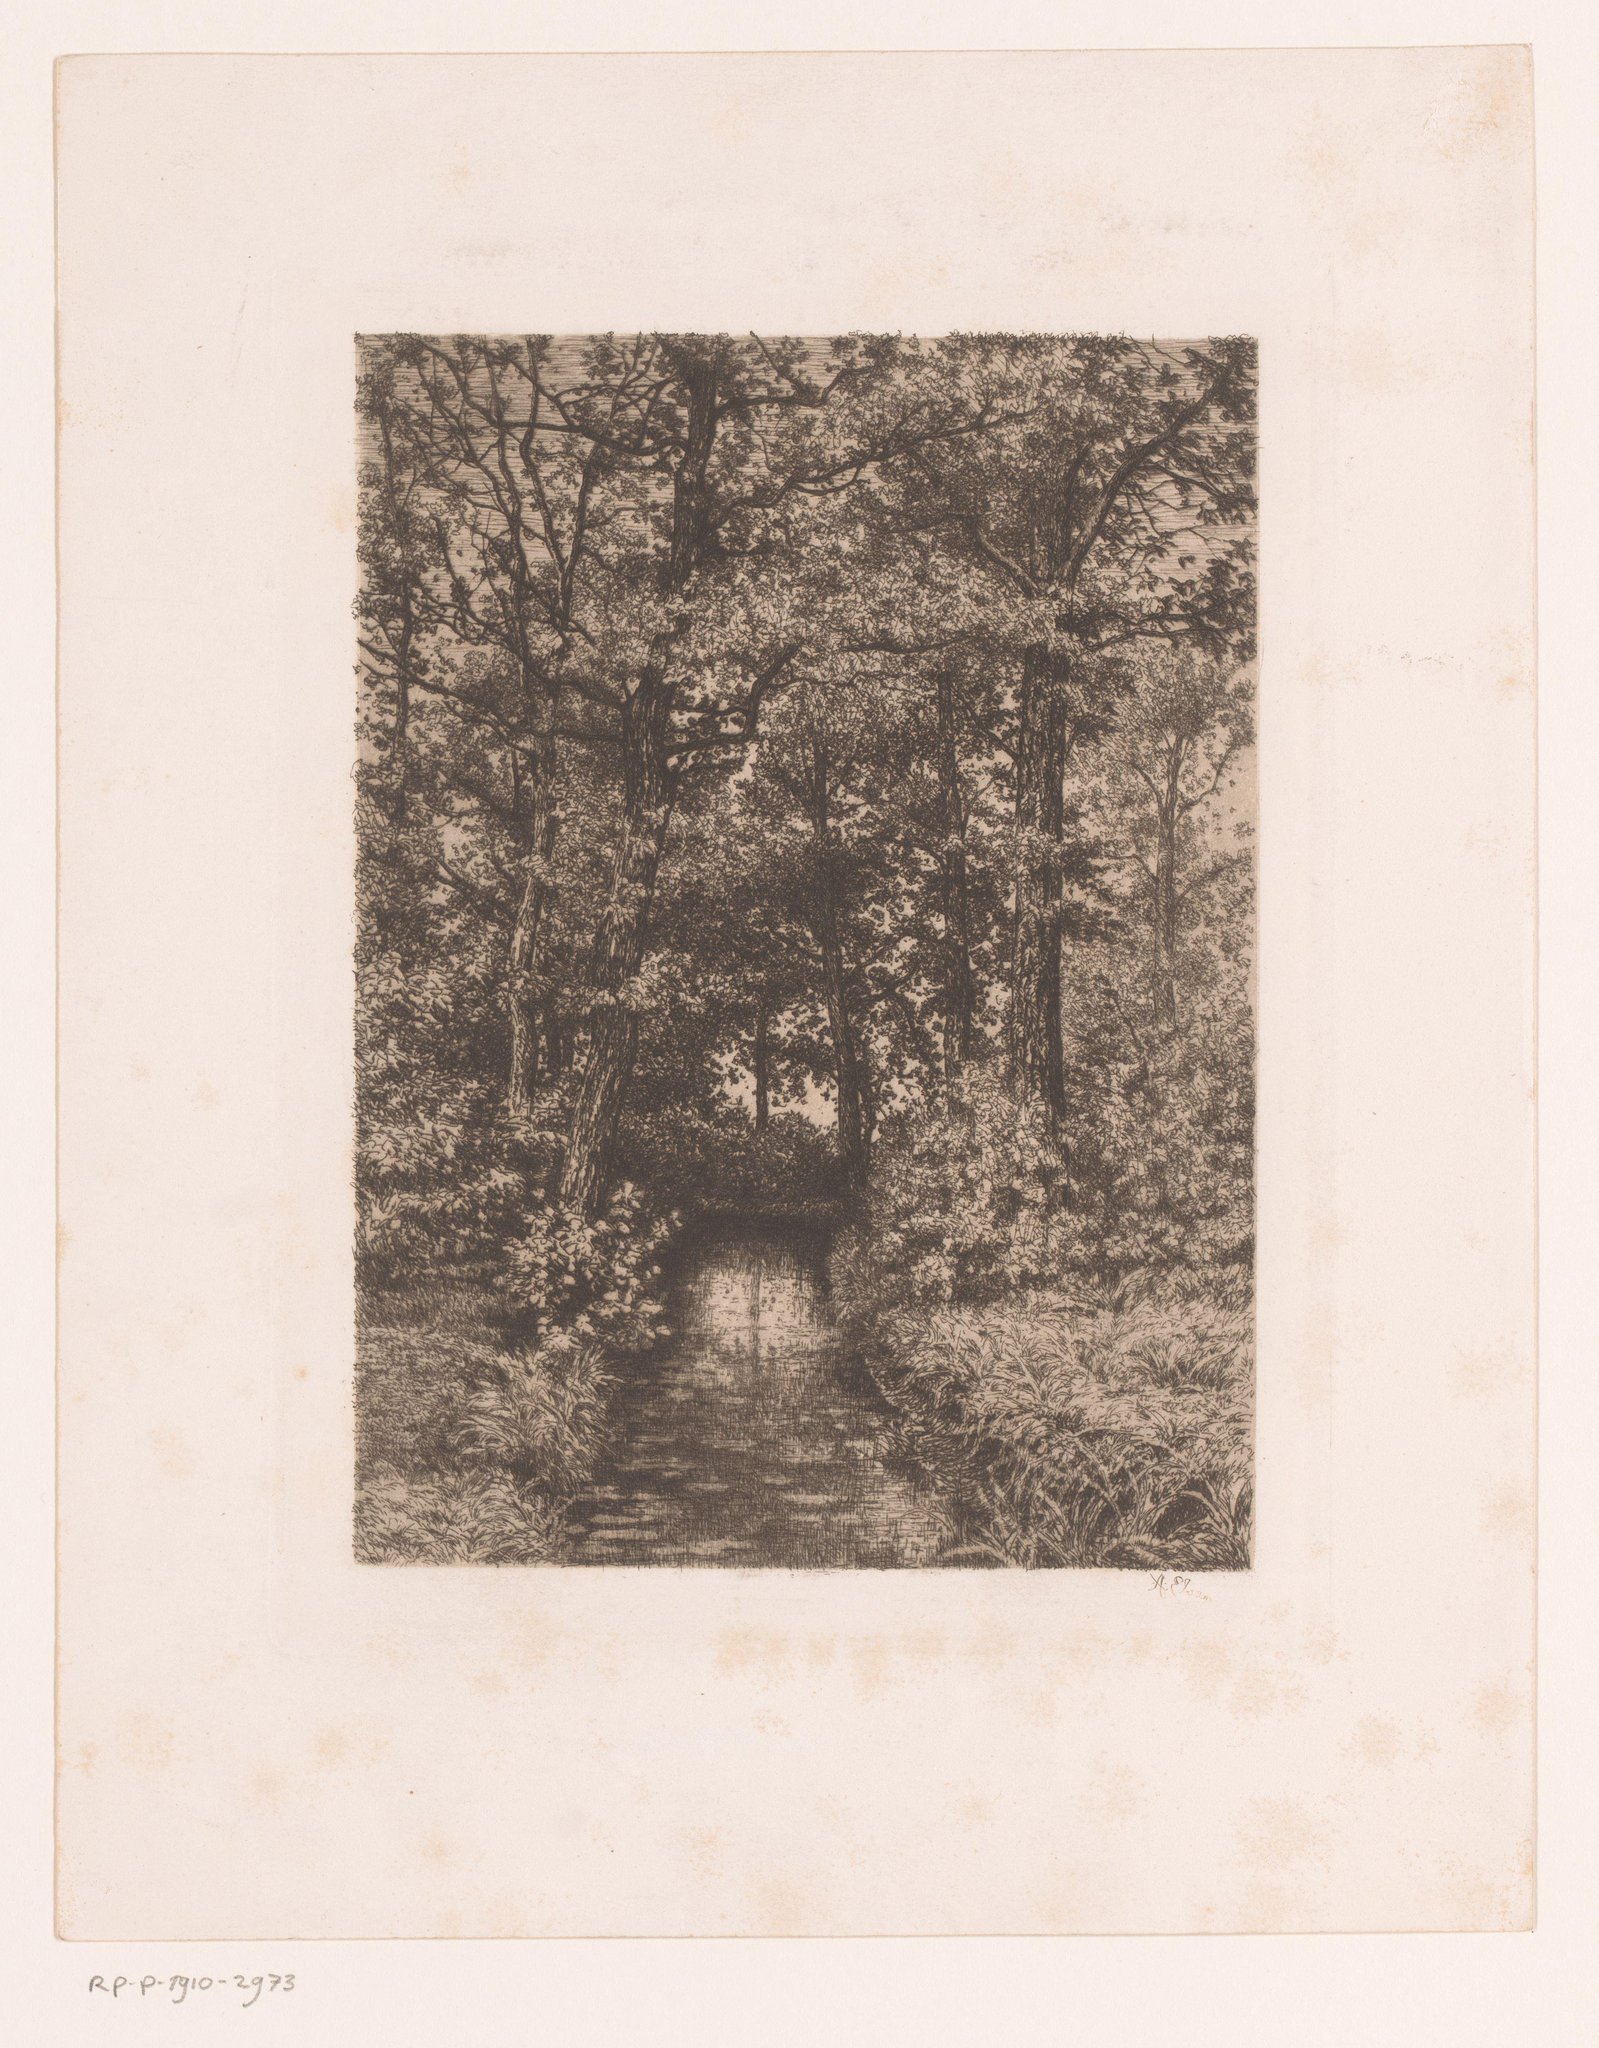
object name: print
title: Bosgezicht met in het midden een beek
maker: alfred elsen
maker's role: painter, print maker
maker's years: 1850-1914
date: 1860-1910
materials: paper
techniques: etching, intaglio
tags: forest, wood, brook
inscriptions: collector's mark: Lugt 2228